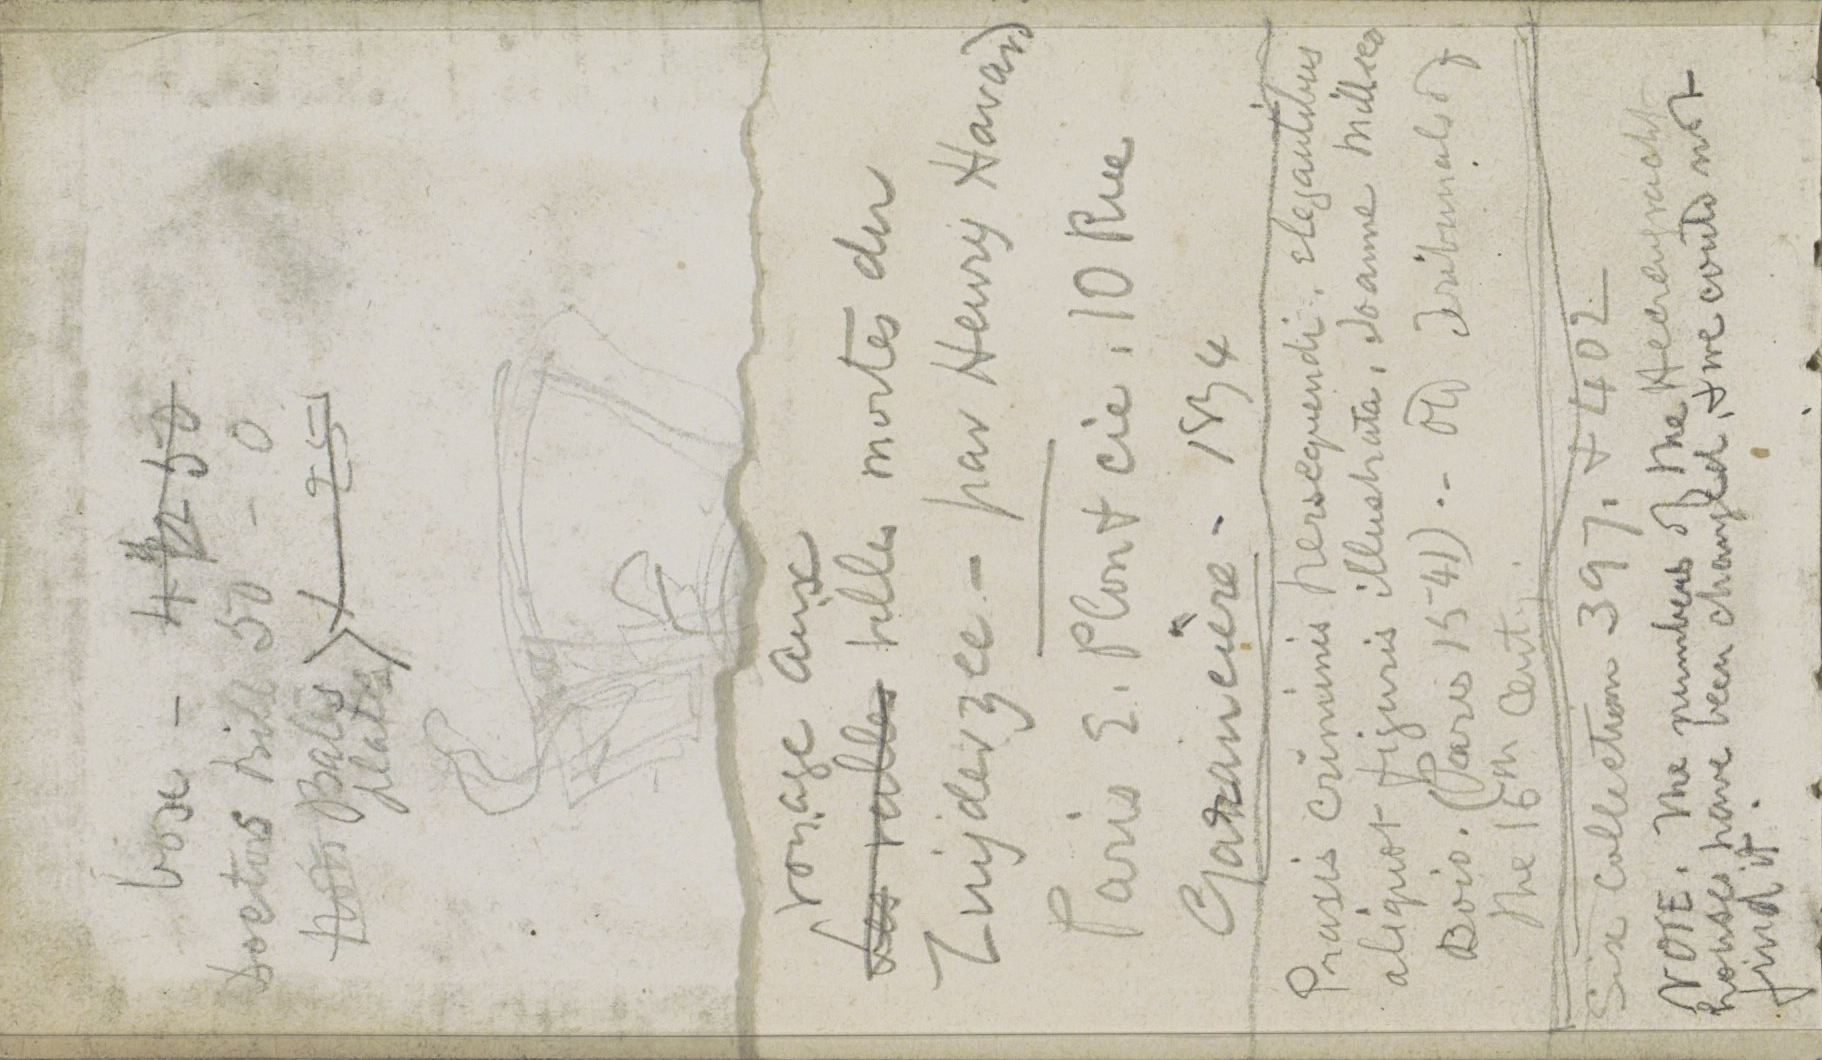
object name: sketchbook leaf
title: Notities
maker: george clausen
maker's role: draughtsman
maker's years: 1852-1912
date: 1875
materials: paper, pencil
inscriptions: annotation: ‘voyage aux/ [...]mortes de[...]/ Zuijderzee - par Henry Harrard/ Paris E. Plont cie. 10 Rue/ Garanciere - [...]/ Praxis criminis persequendi, elegantibus/ aliquot figuris illustrata, Jo[...]ne Mill[...]/ Doio (Paris 1541) - old Tribunals of/ the 16th cent./ See collection 397, + 402/ Vote, the numbers of the Heerengracht/ houses have been changed, + we could not find it’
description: Blad 1 verso uit een schetsboek met 46 bladen.